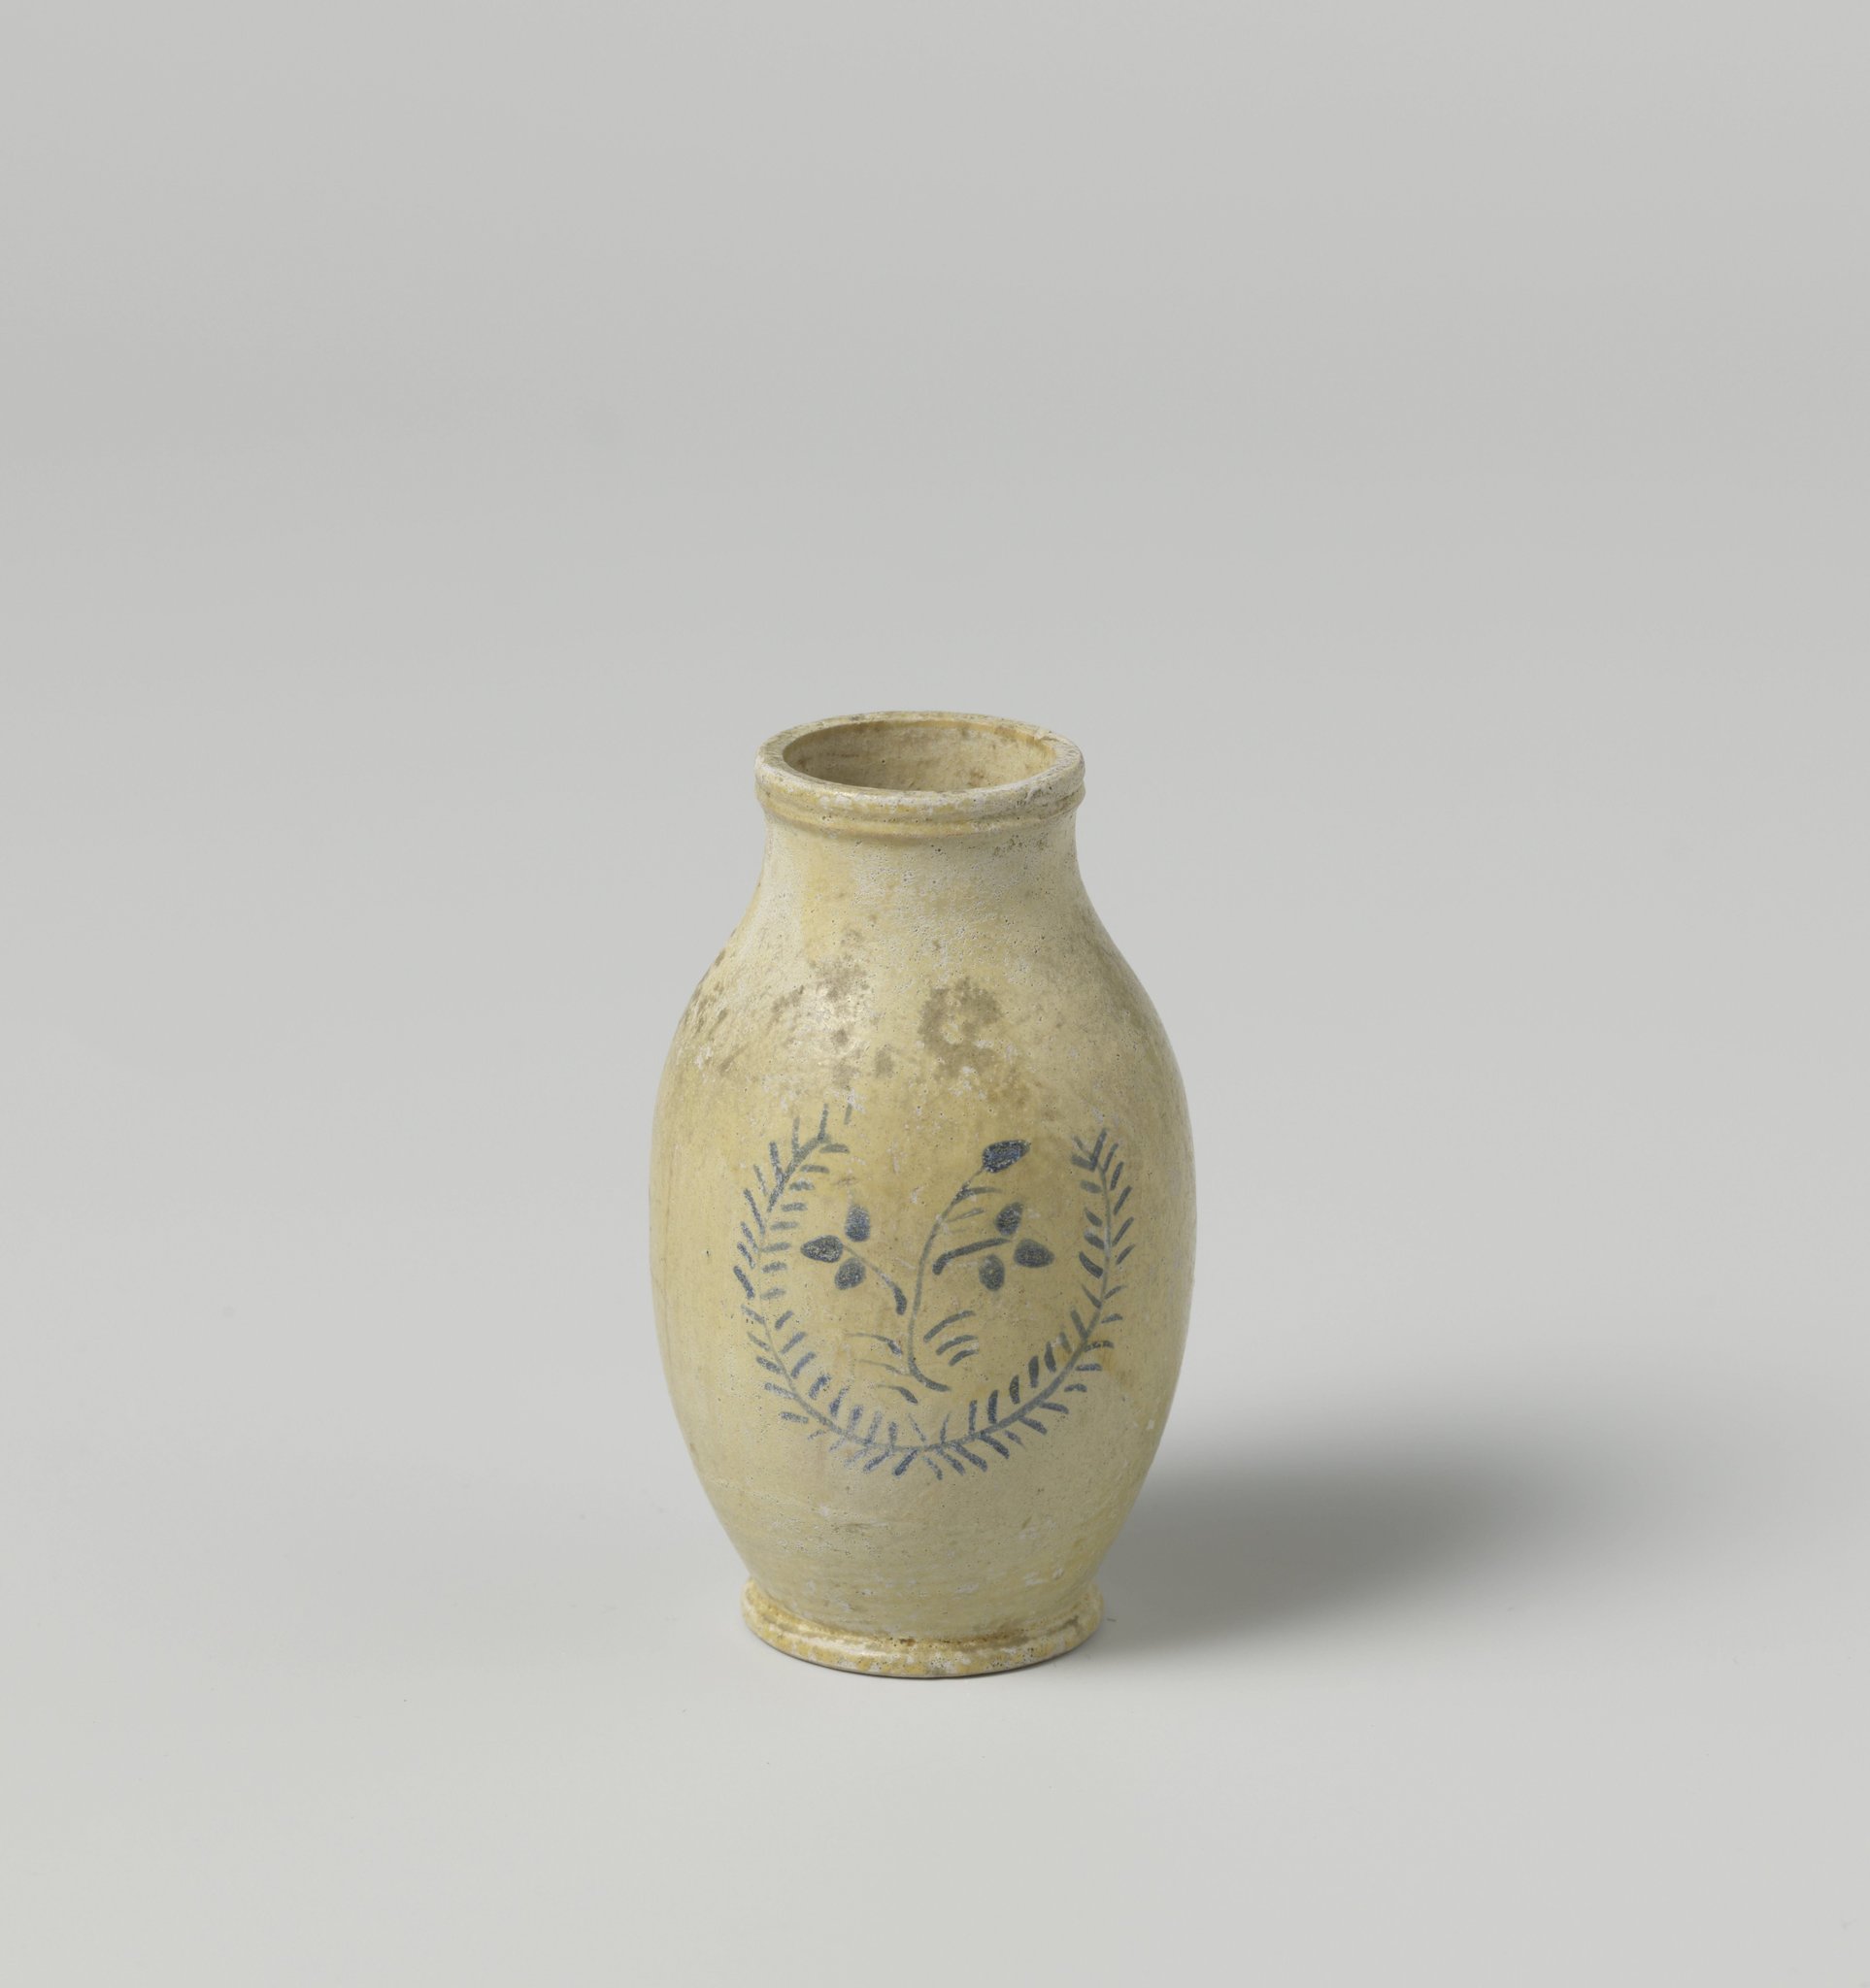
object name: jug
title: Kruik, versierd met blauwe bloem- en rankmotieven op een wit fond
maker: Anonymous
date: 1700-1799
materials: wood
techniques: painted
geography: amsterdam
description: Een kruik, gedraaid van hout, wit geschilderd en versierd met blauwe bloem- en bladrank. Twee aanzetpunten voor oor (afgebroken). Imitatie Delfts aardewerk.